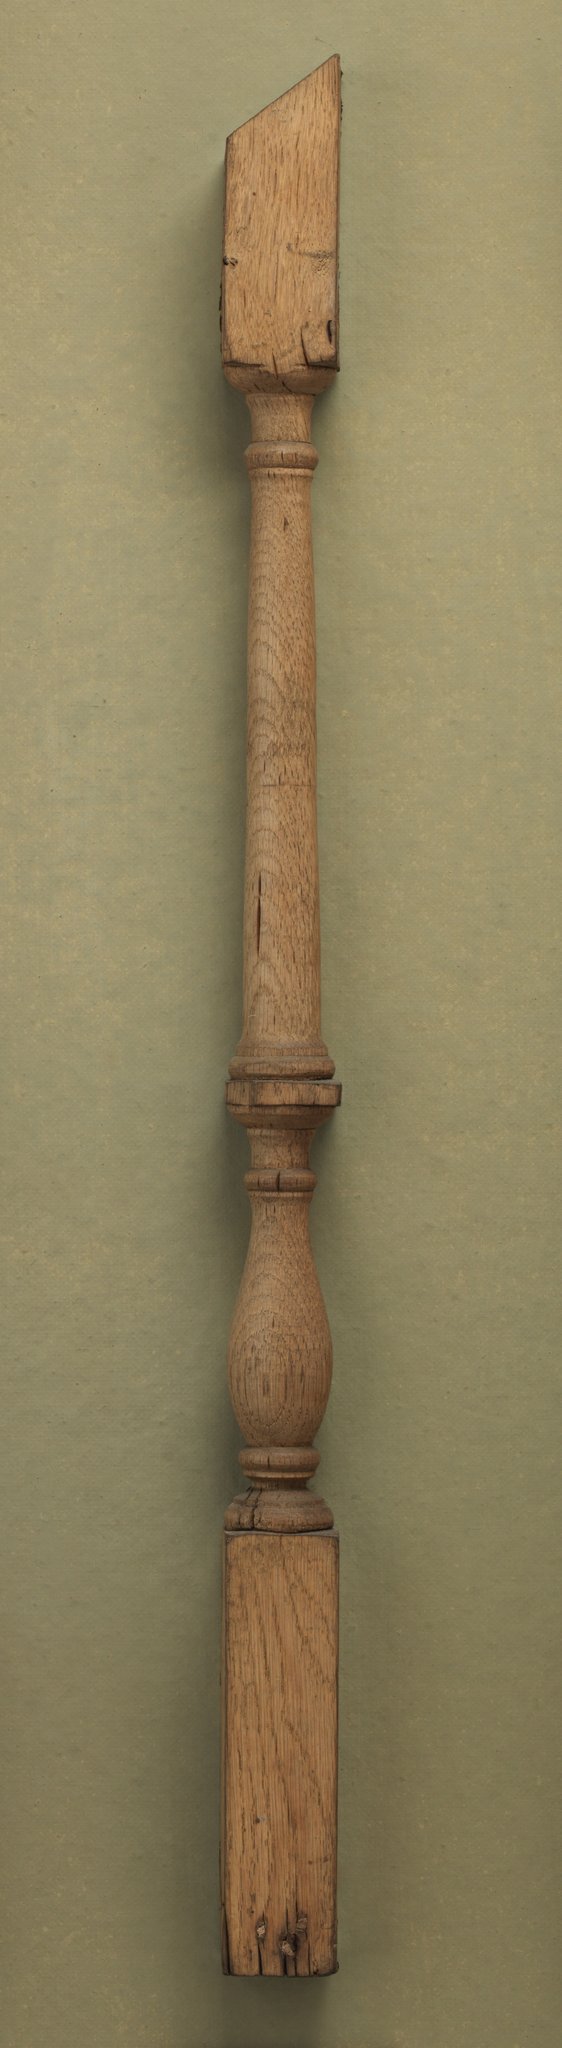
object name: baluster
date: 1734-1766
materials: wood